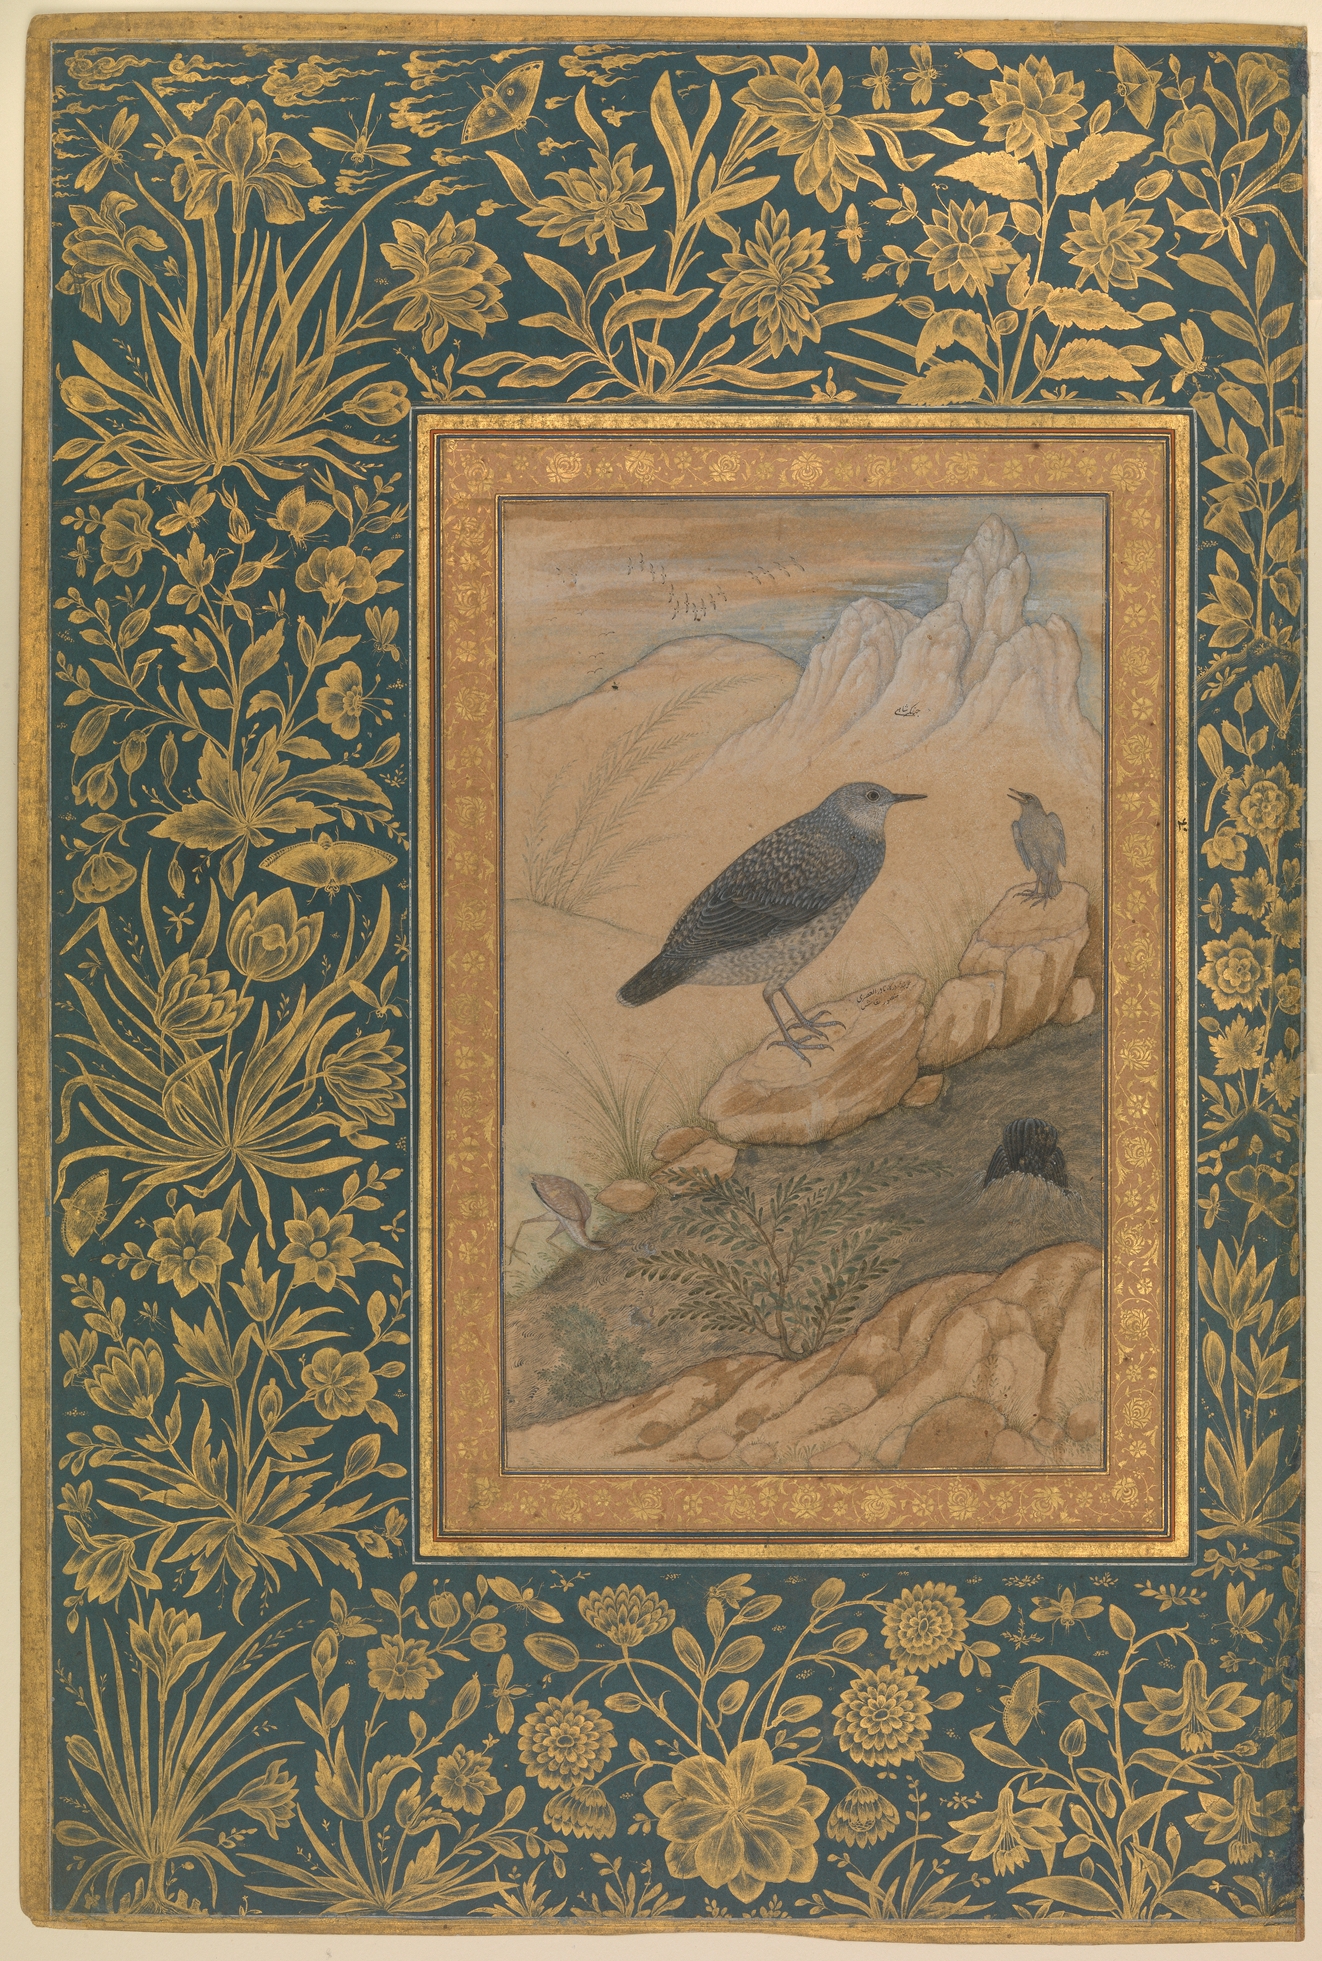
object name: album leaf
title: "Diving Dipper and Other Birds", Folio from the Shah Jahan Album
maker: mansur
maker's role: artist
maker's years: 1584-1626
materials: gold, ink, paper, watercolor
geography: india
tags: birds,flowers